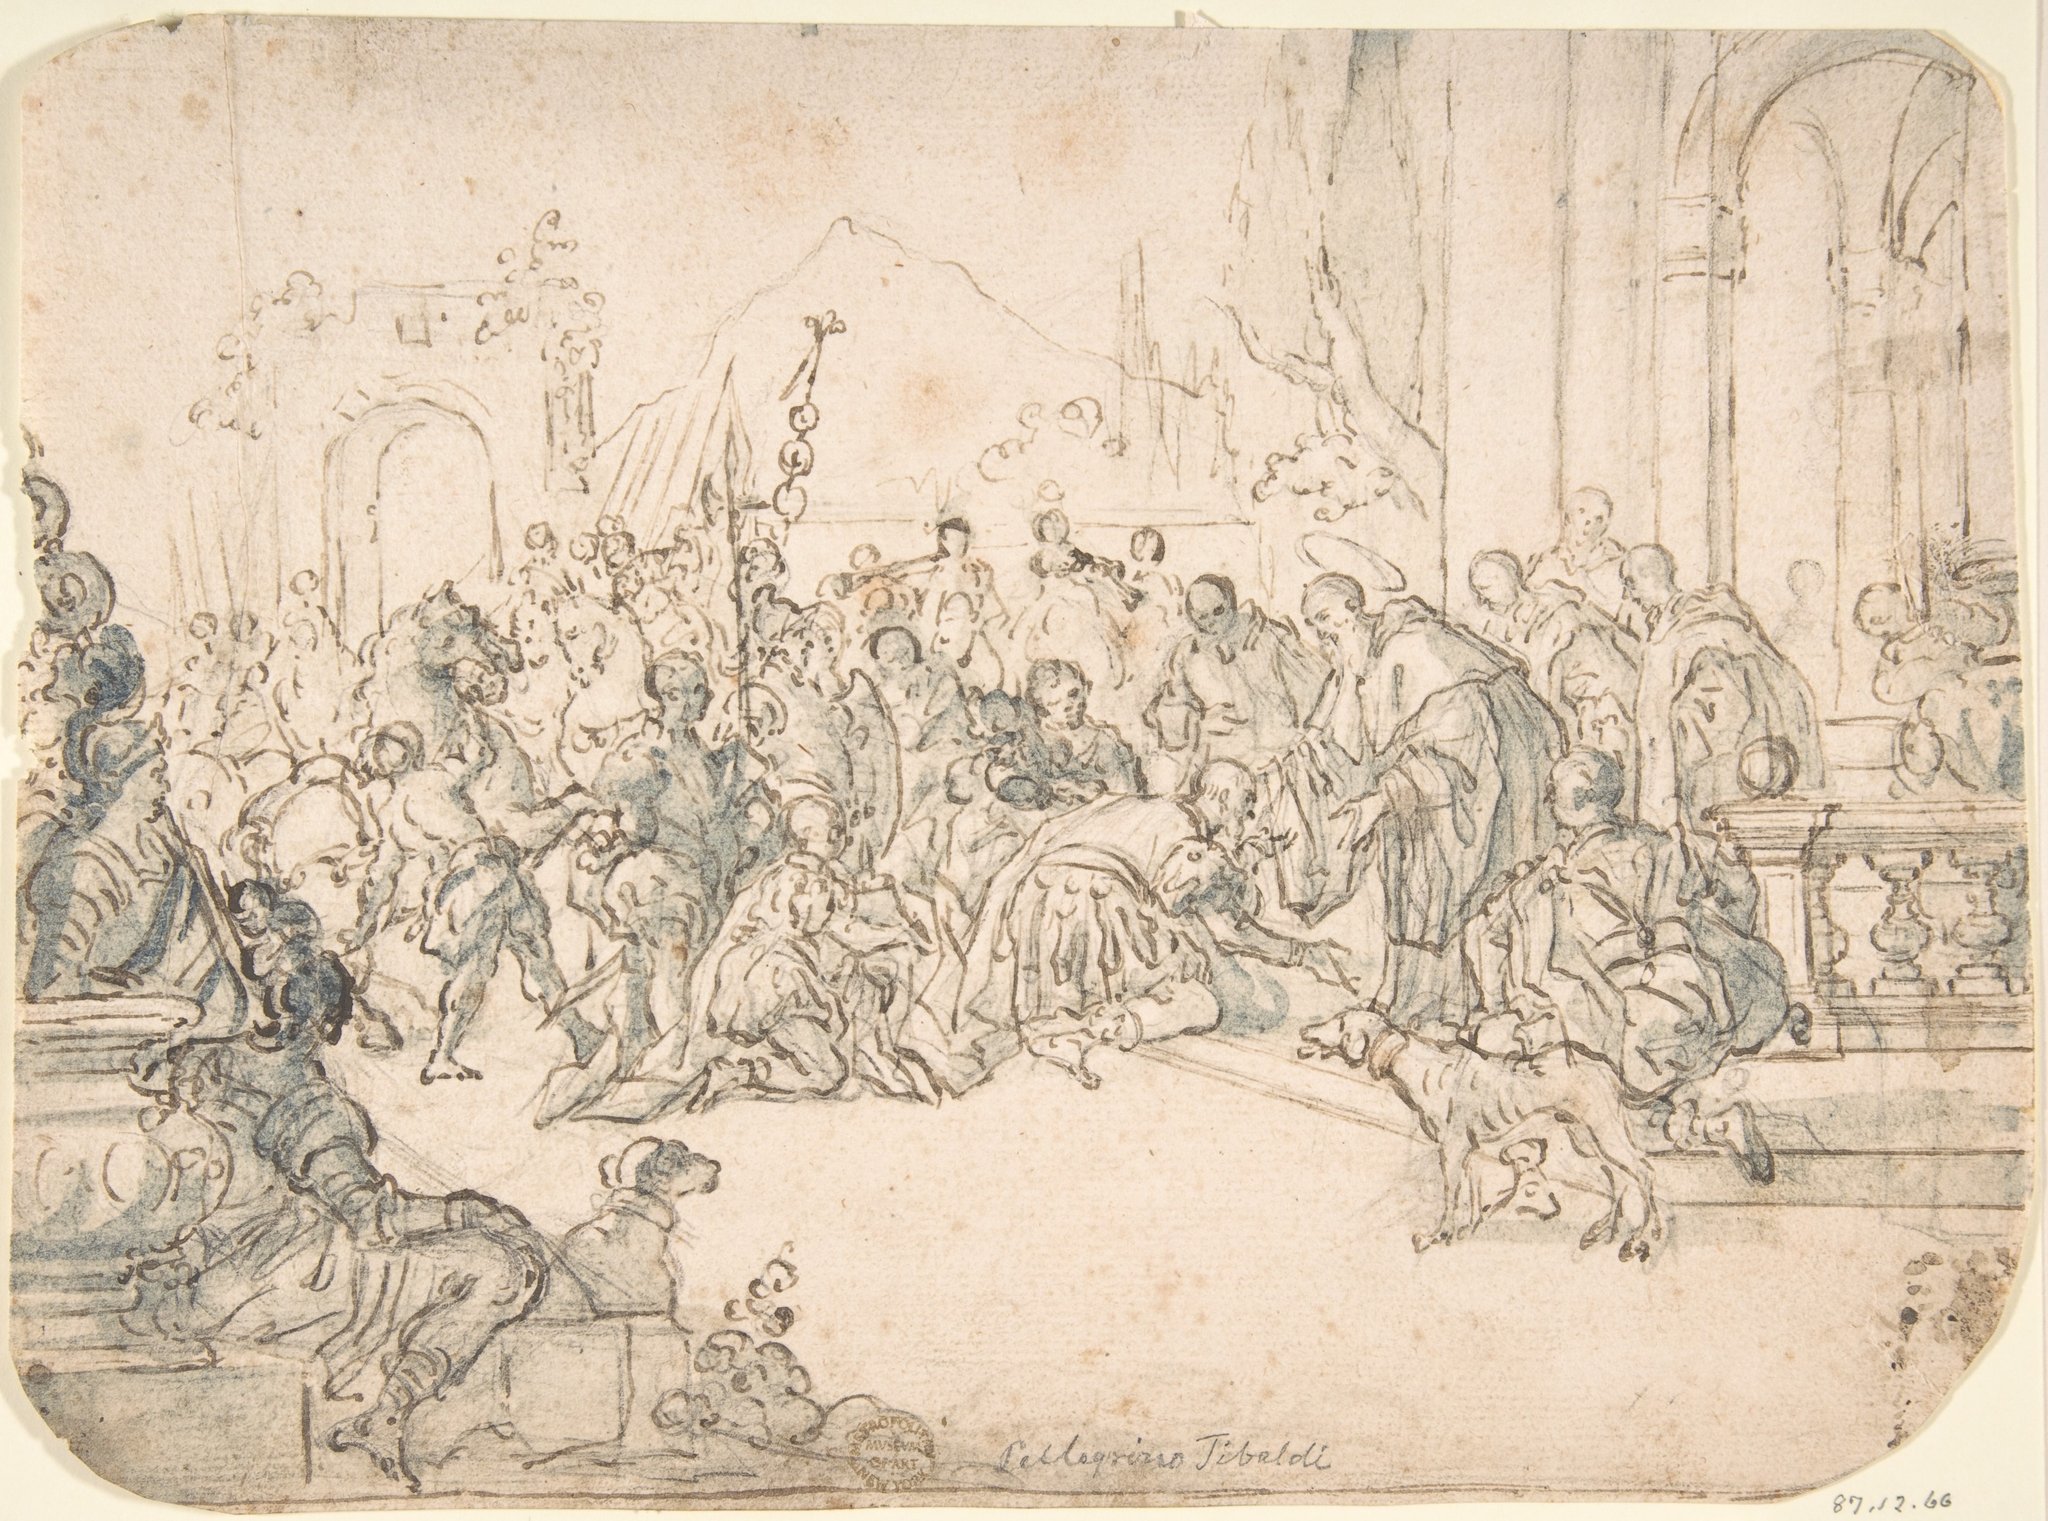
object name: drawing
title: Saint Benedict Receiving a Warrior (recto); Sketch of Crowded Narrative Scene (verso)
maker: anonymous, italian, roman-bolognese, 17th century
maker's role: artist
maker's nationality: italian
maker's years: 1600-1700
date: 1601-1700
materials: charcoal, ink, paper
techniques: brush, pen, wash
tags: dogs,saints,crowd